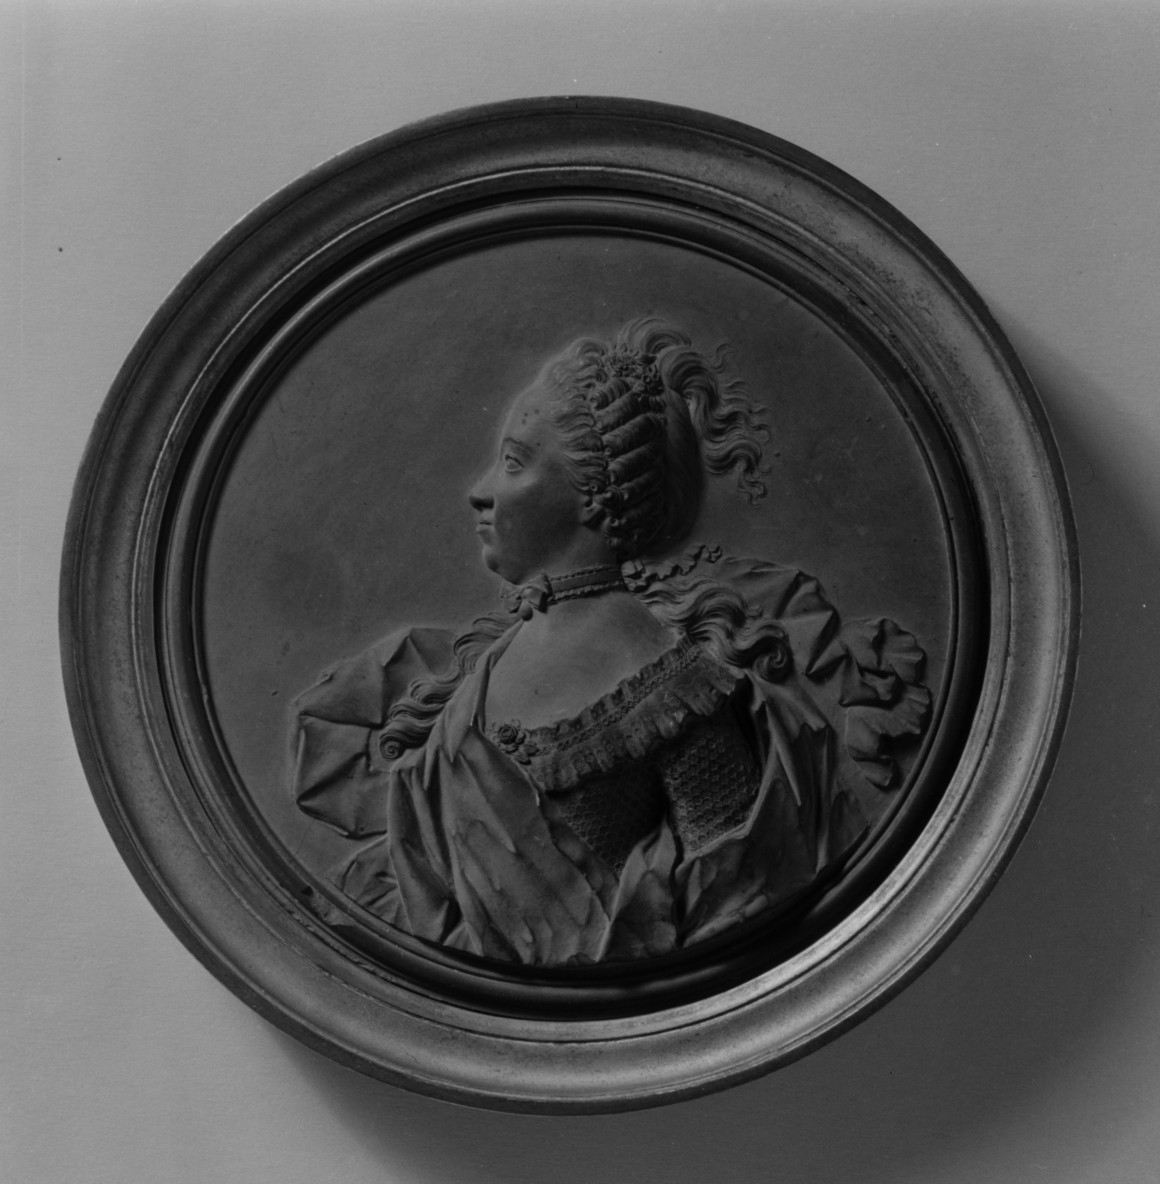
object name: medallion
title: Portrait of a lady, possibly the Marquise de Vaudreuil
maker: jean-baptiste nini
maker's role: artist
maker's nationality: italian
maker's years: 1717-1786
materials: gilt, terracotta, wood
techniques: casting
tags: profiles,women